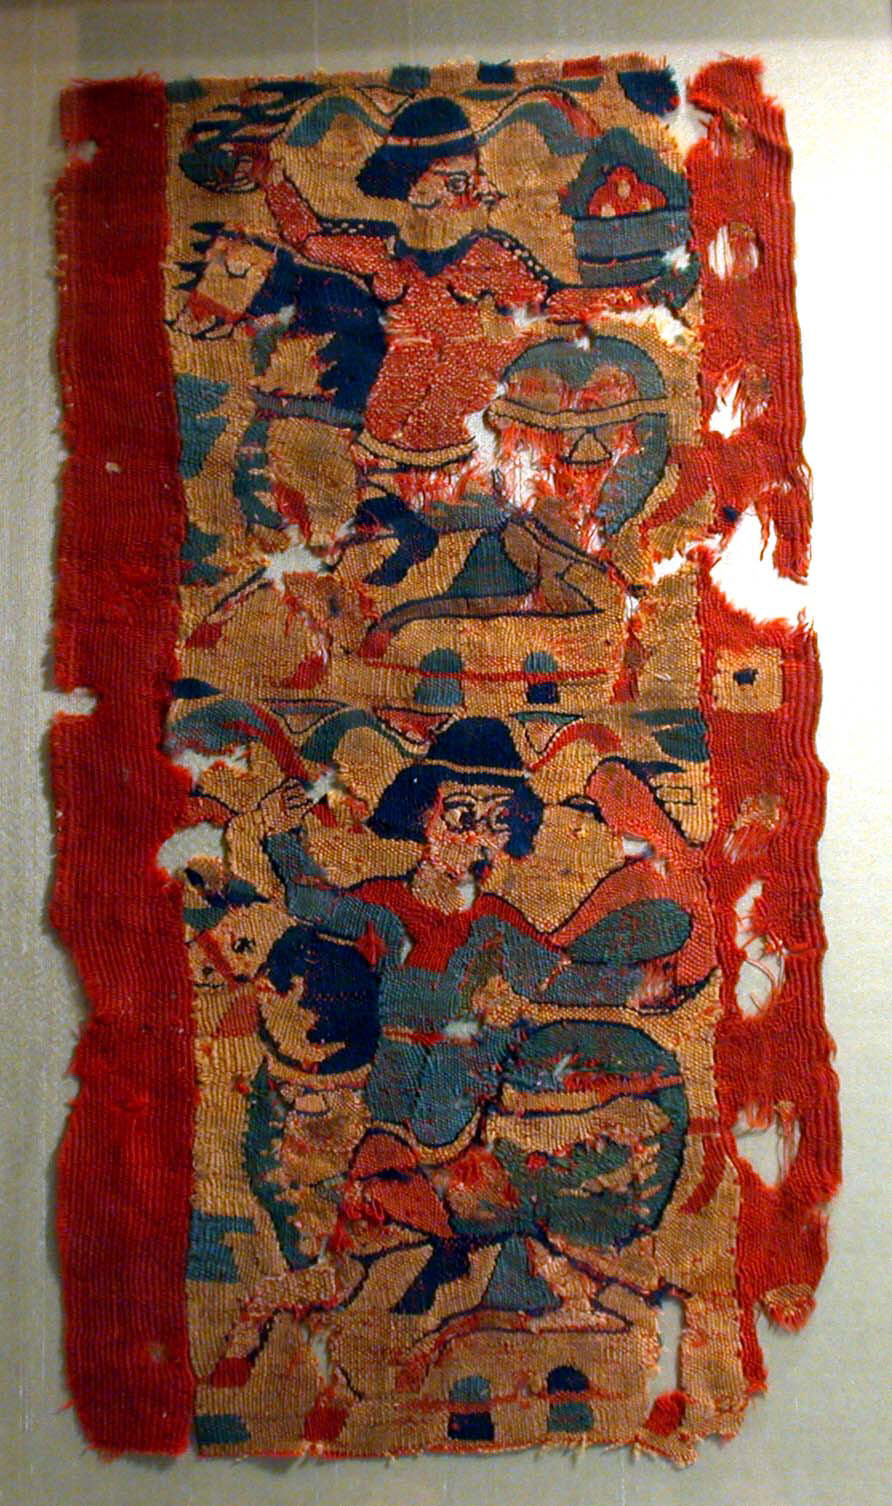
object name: textile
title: Band with two horsemen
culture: coptic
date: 701-900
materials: wool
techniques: polychrome, tapestry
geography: egypt